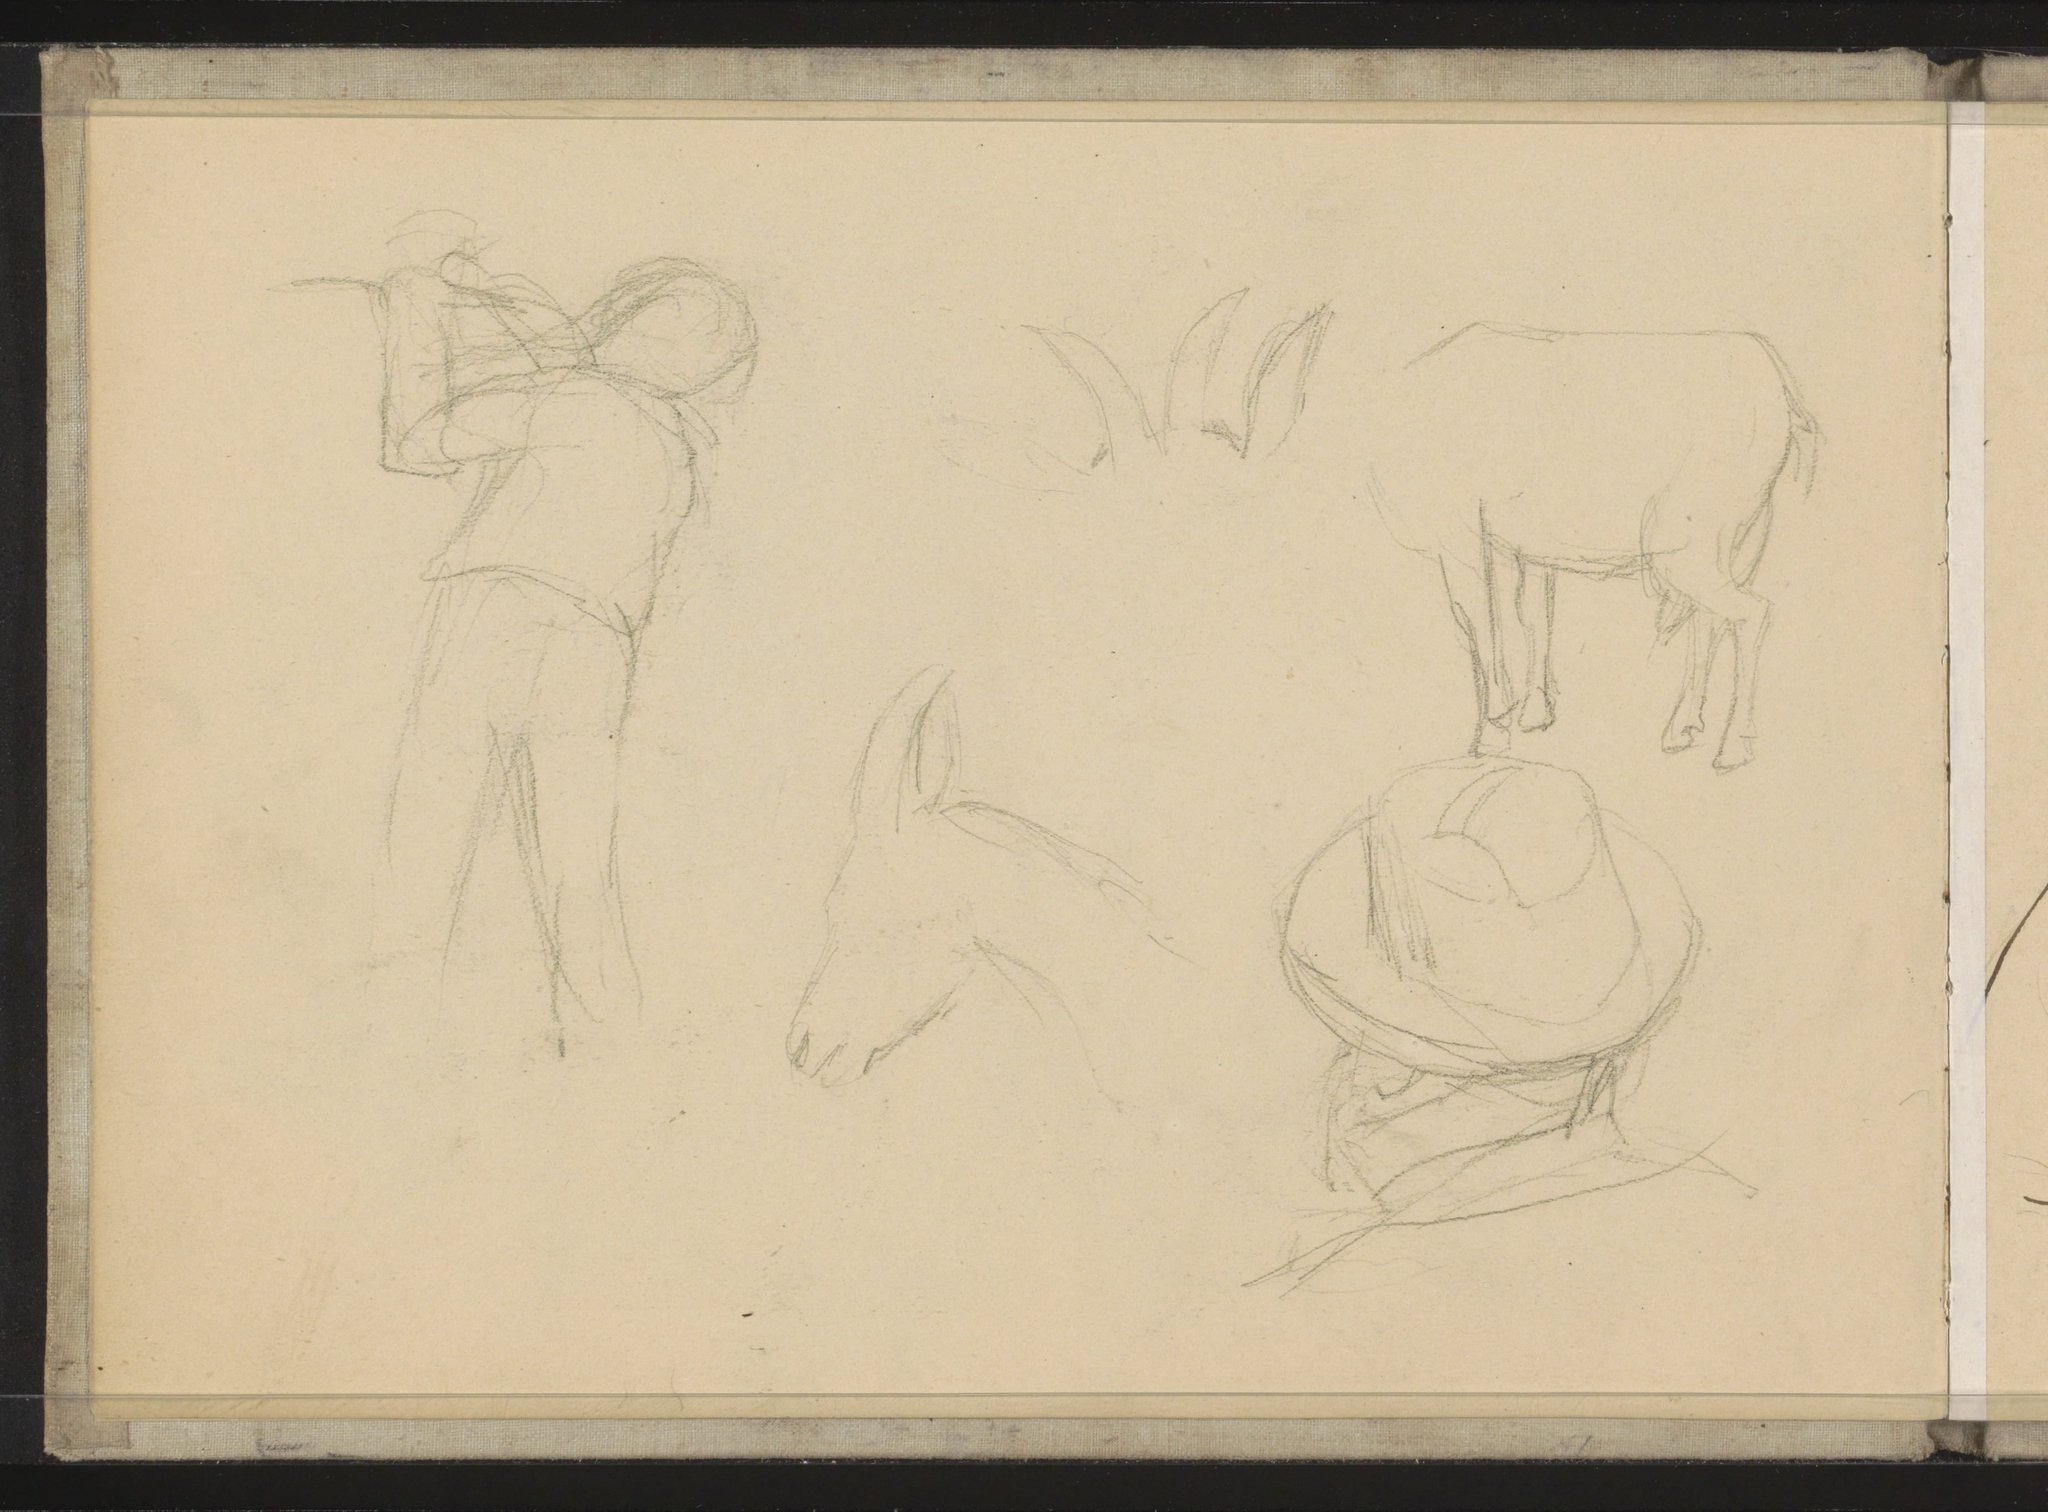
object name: sketchbook leaf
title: Studieblad, onder andere met geiten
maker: jozef israëls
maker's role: draughtsman, painter, print maker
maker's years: 1824-1911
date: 1834-1911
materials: paper, pencil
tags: head (human) (+ male human being (not to be used where -a- is prescribed)), goat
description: Tevens studies van een mannenkop met hoed en een figuur met opgeheven armen en een voorwerp in de handen. Blad 2 verso uit een schetsboek met 18 bladen.